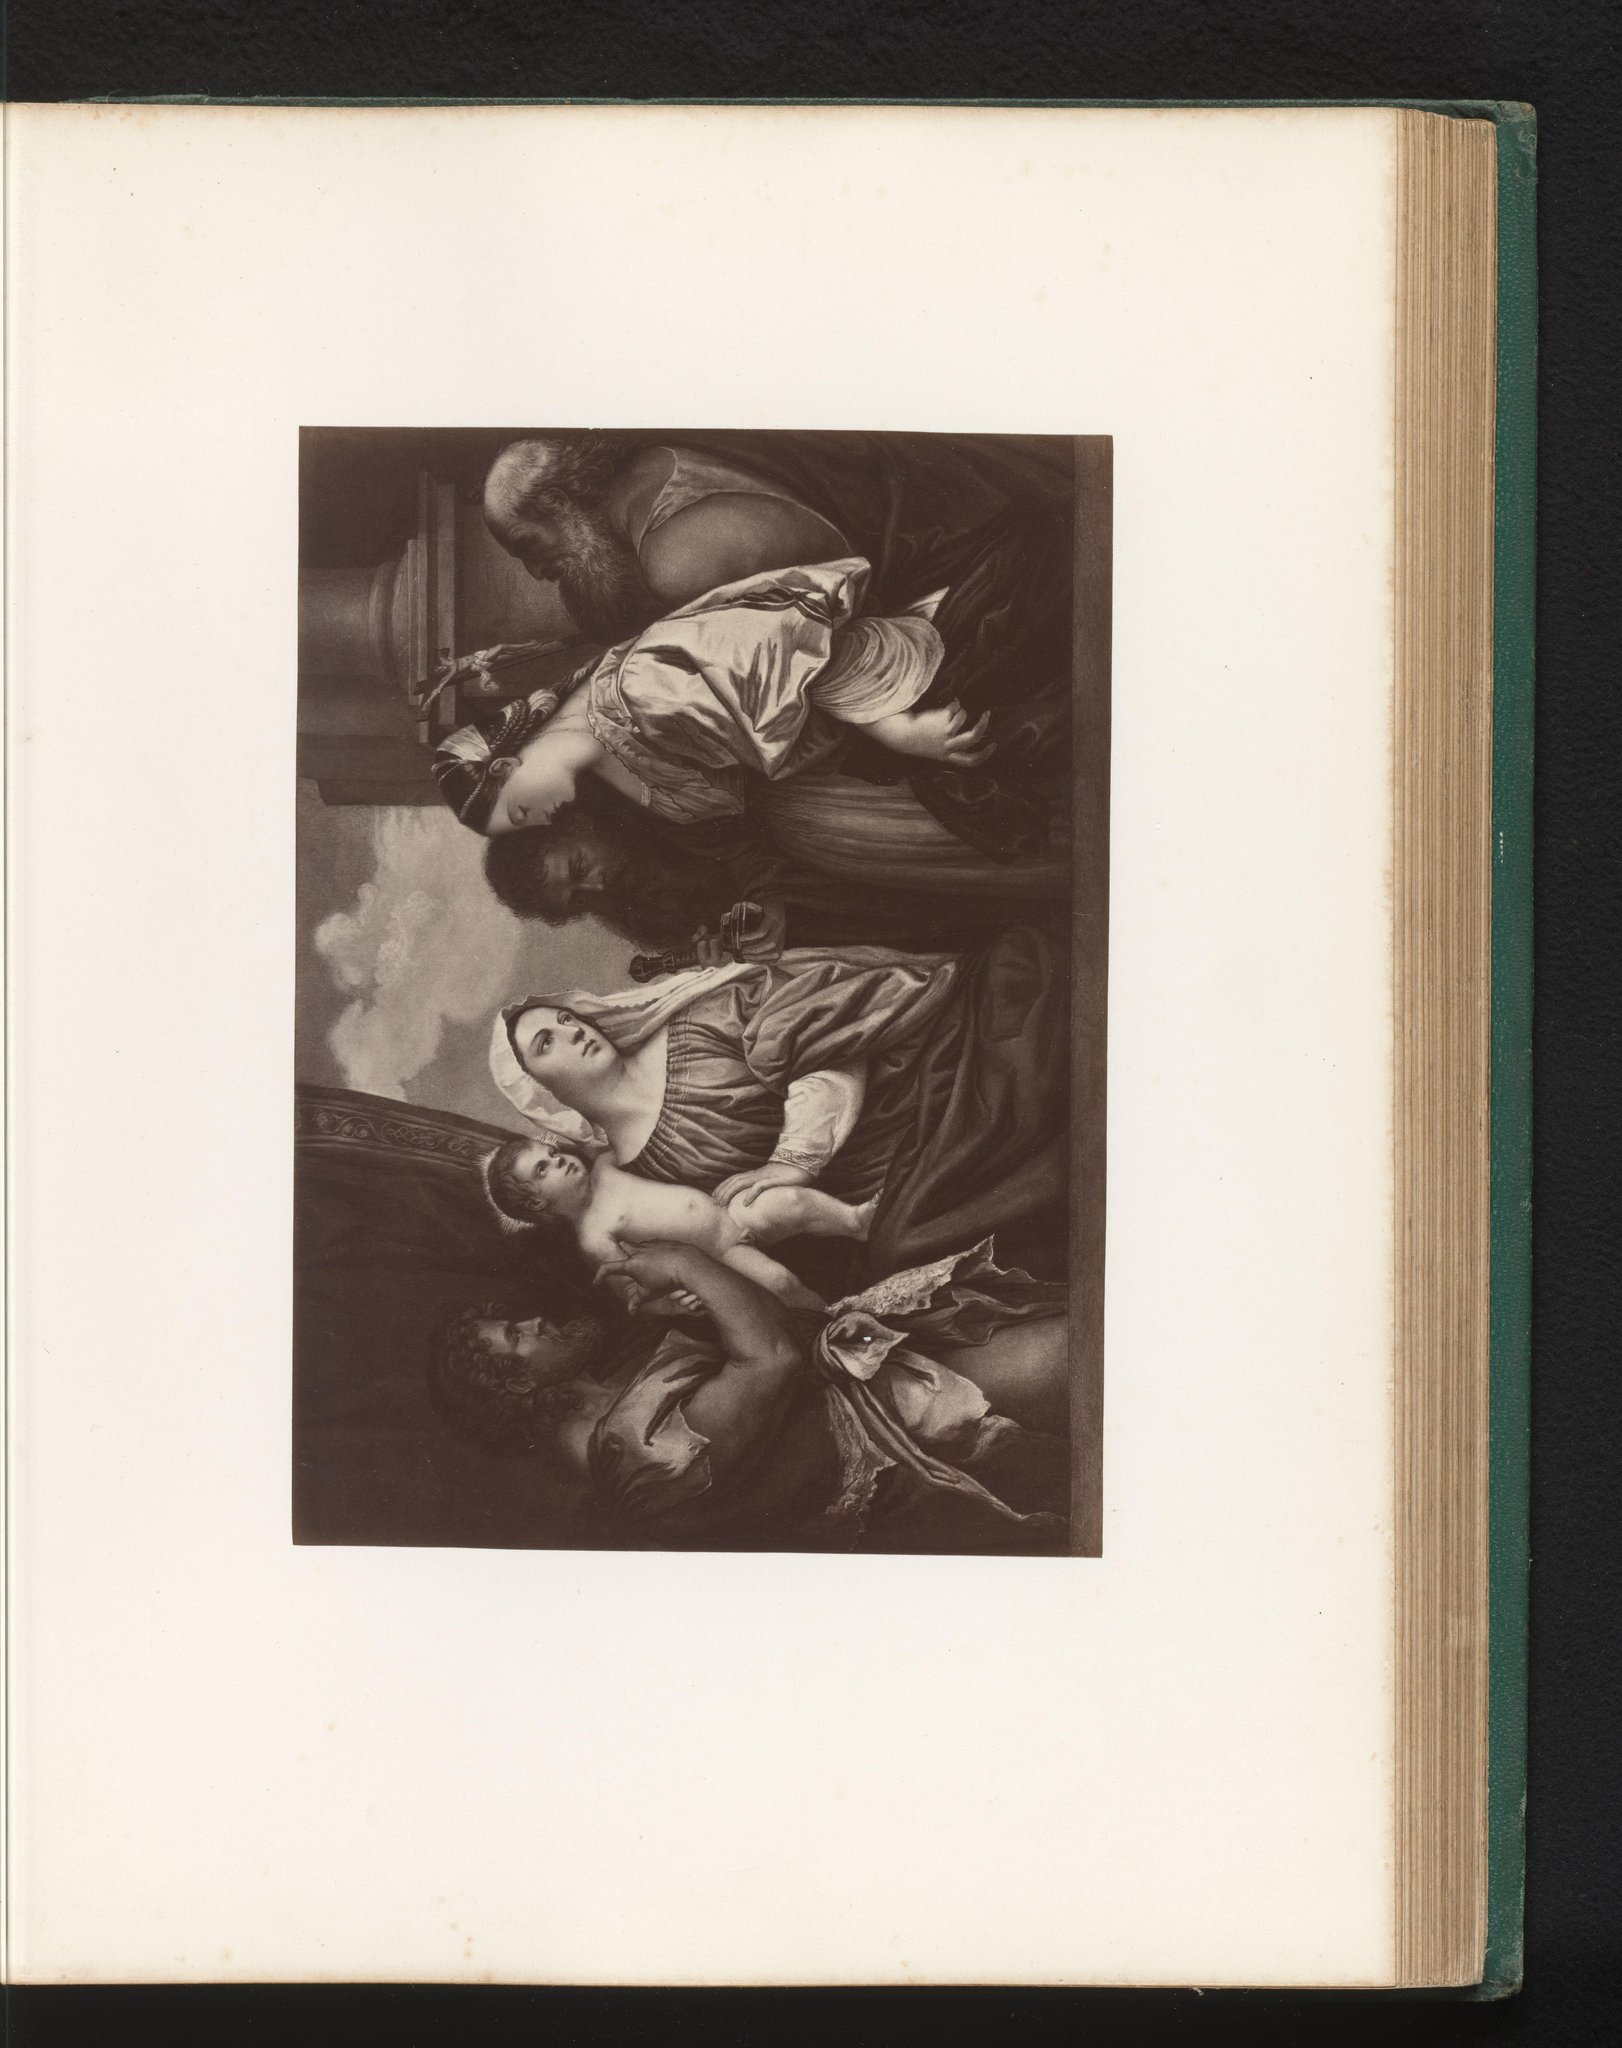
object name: photograph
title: Tizian: Madonna mit der weissgekleideten Frau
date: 1870-1875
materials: paper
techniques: albumen print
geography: berlin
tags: madonna (i.e. mary with the christ-child) accompanied or surrounded by others